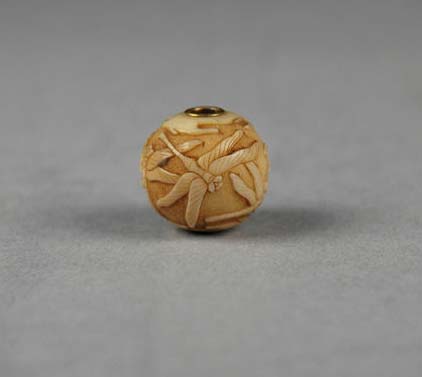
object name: bead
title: Carved Bead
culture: japanese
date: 1801-1900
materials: ivory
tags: dragonflies